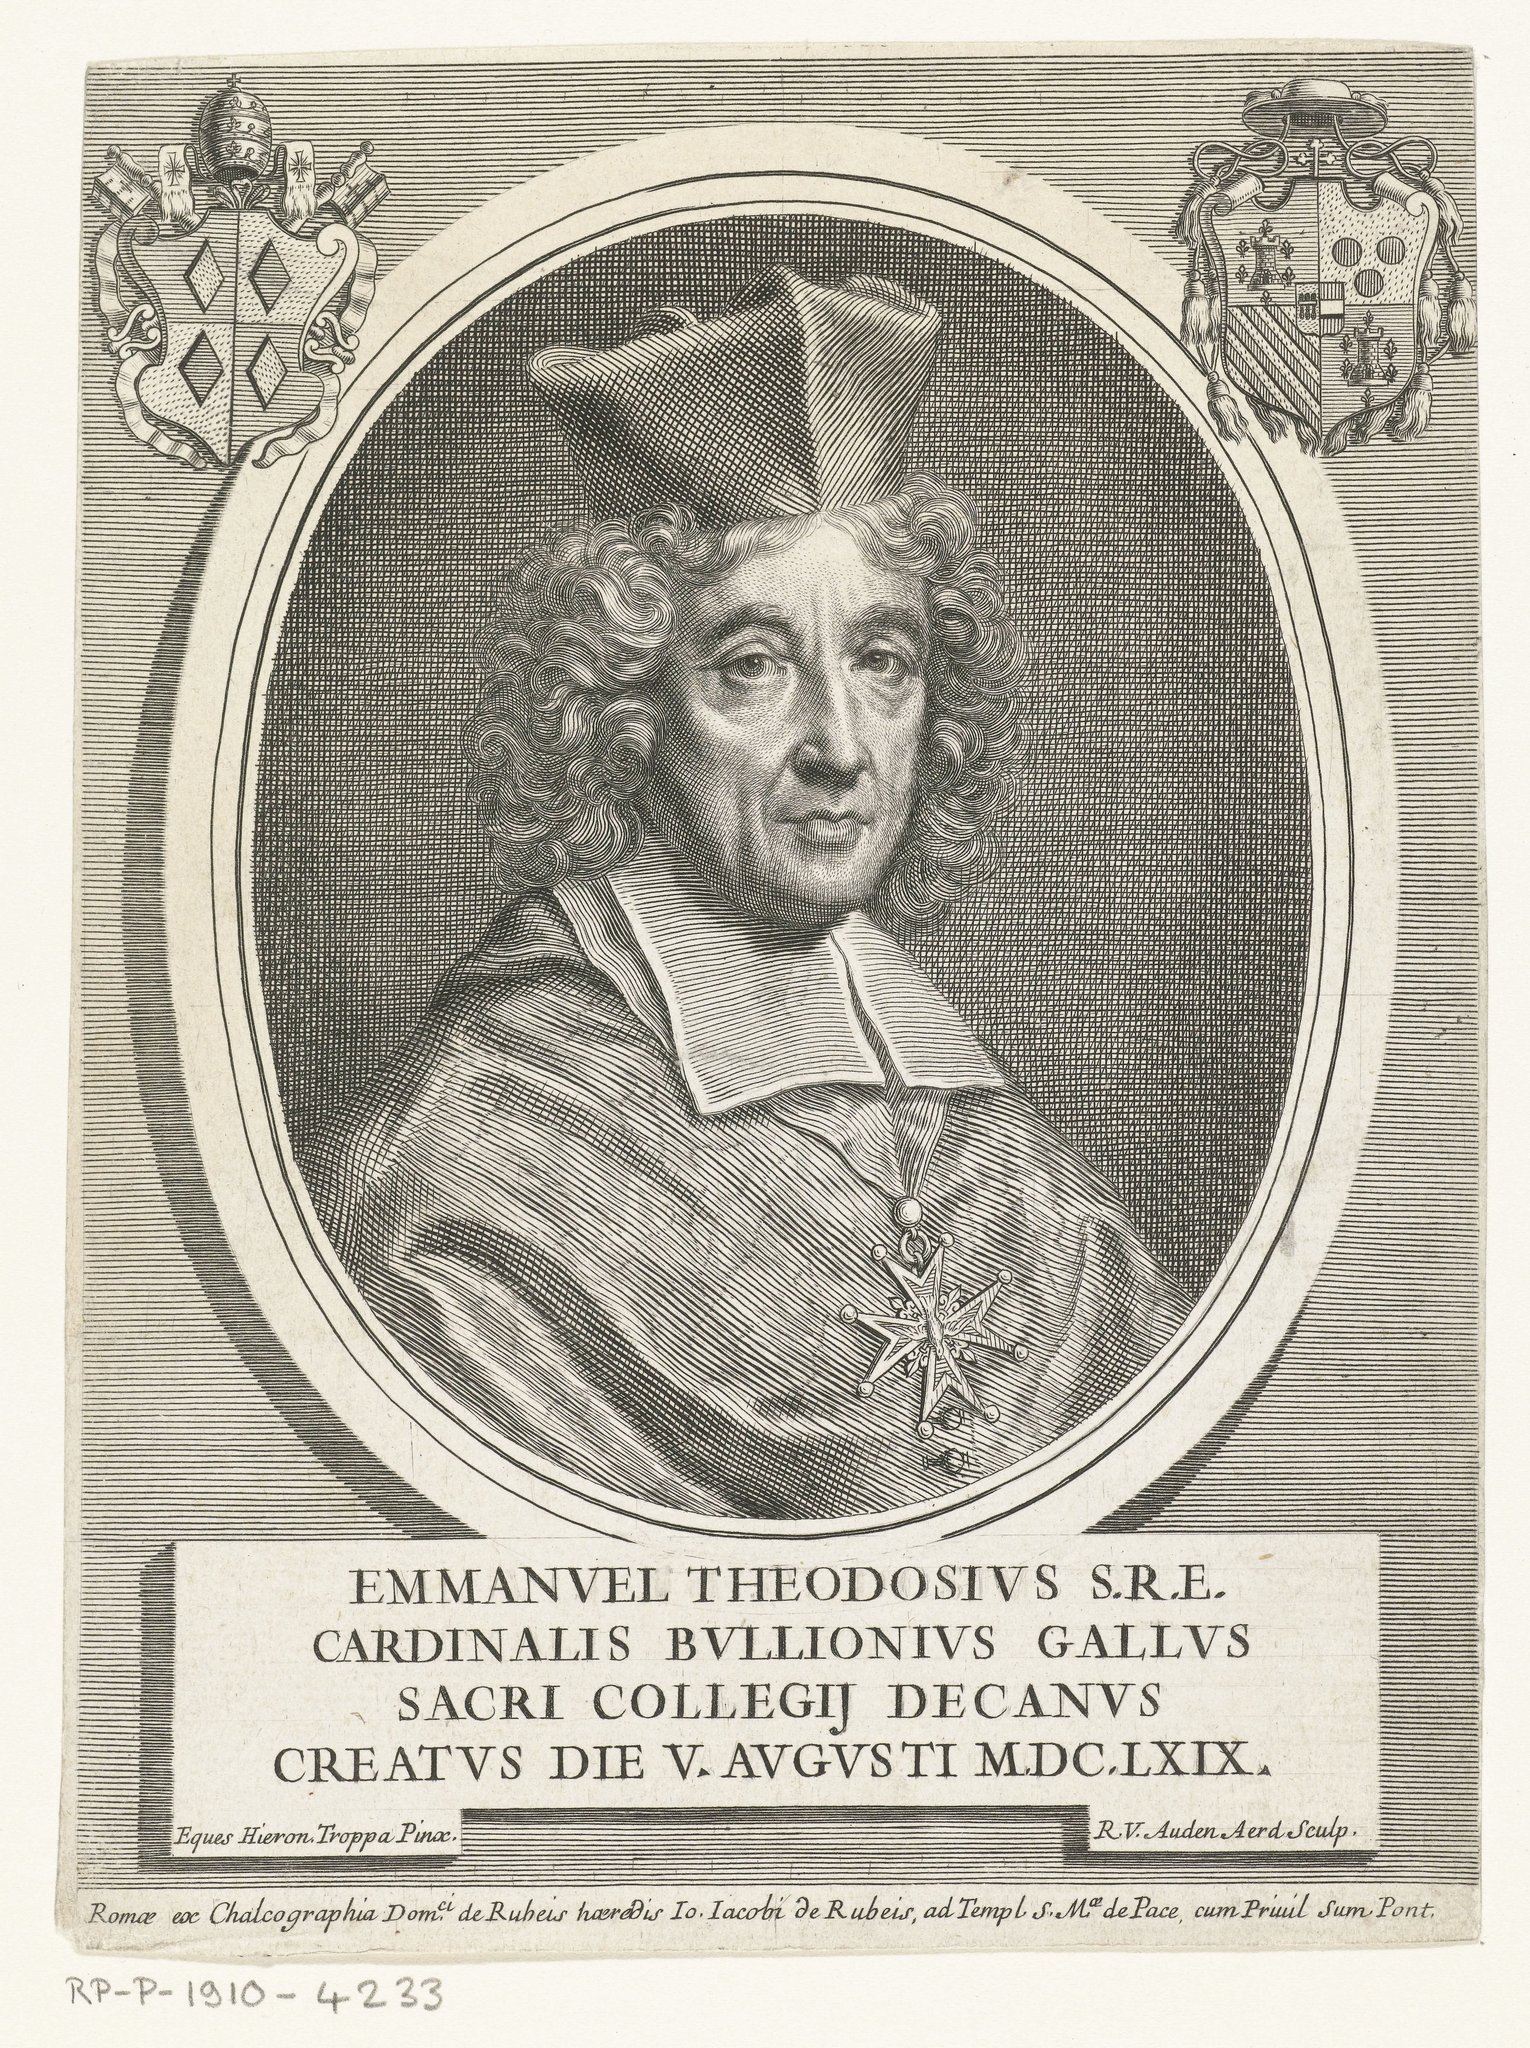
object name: print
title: Portret van kardinaal Emmanuel Théodose de Bouillon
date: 1685-1723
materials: paper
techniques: engraving, etching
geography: rome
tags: rome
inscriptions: collector's mark: Lugt 2228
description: Borstbeeld van kardinaal Emmanuel Théodose de Bouillon. In de bovenhoeken links het pauselijk wapen van Clemens IX, en rechts zijn eigen kardinaalswapen. Onder het portret zijn naam en titels.